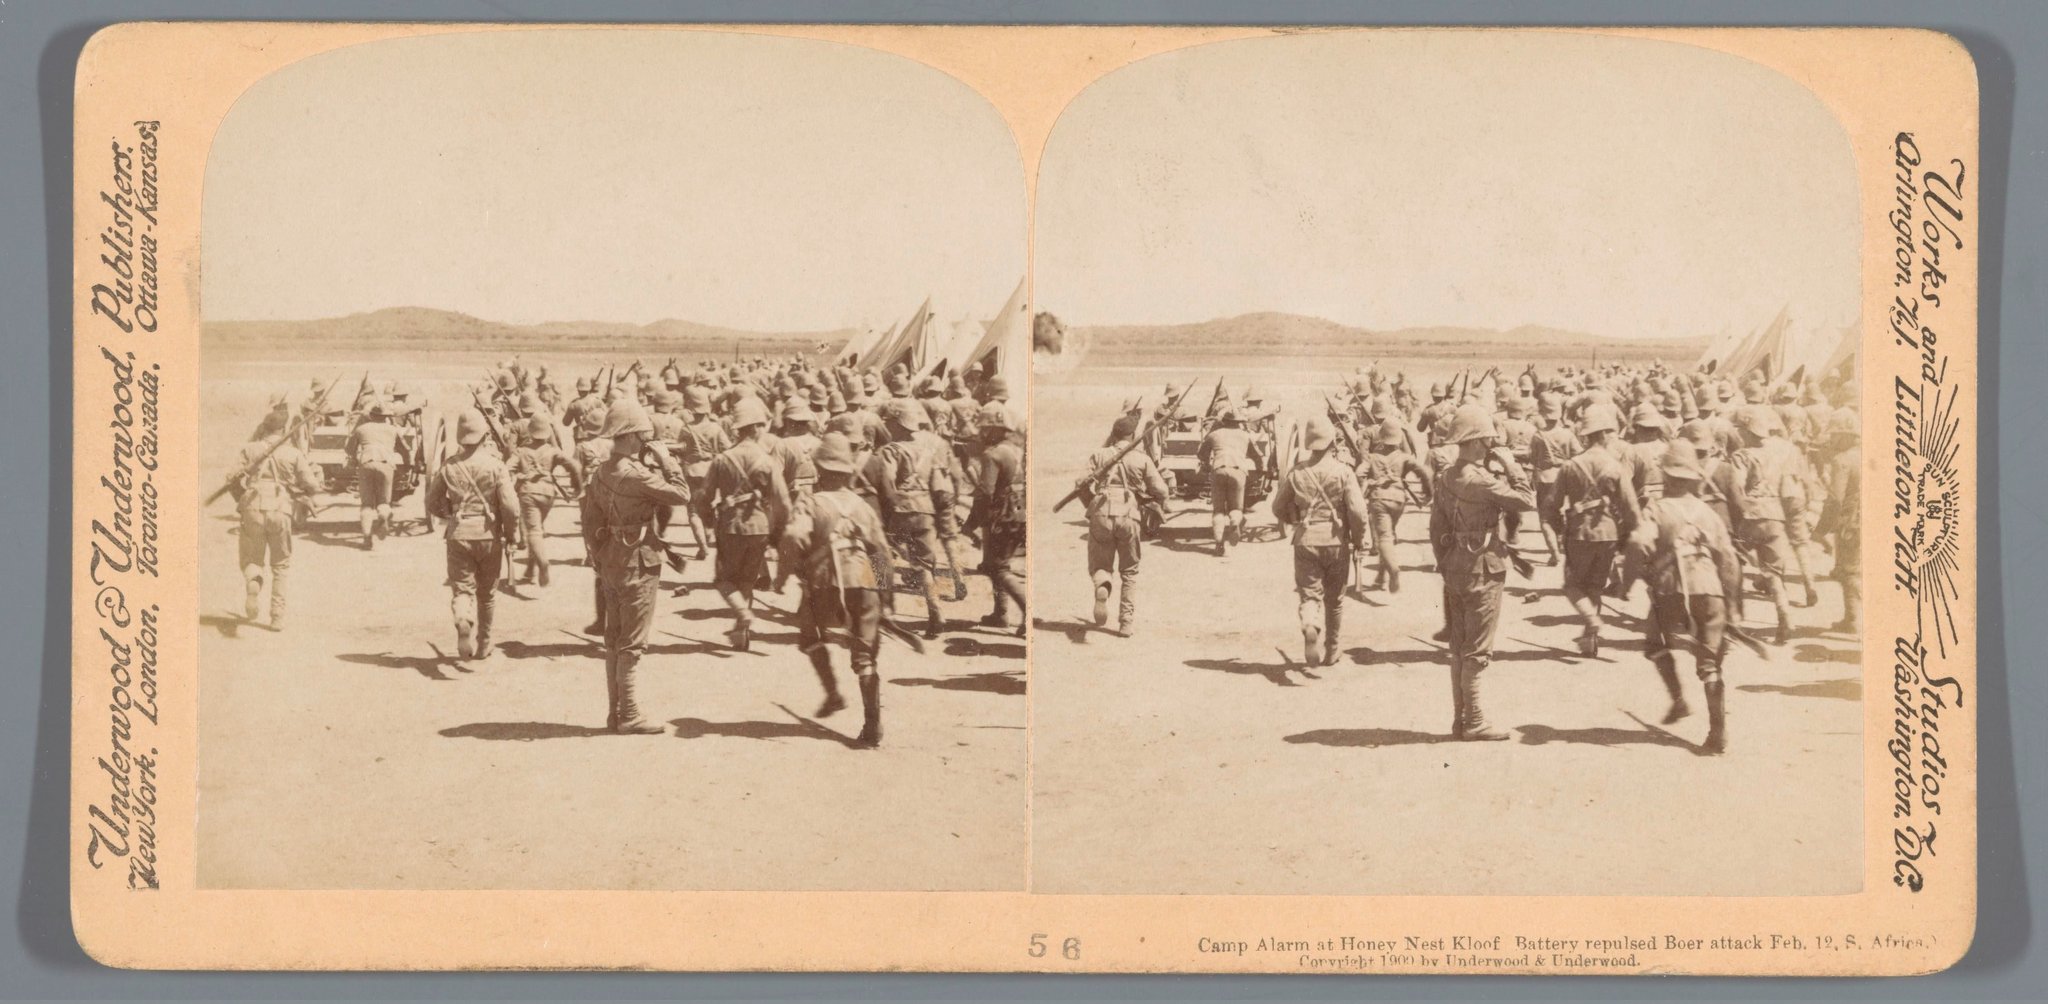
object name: stereograph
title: Gezicht op Britse soldaten op een vlakte bij Honey Nest Kloof nadat een aanval van de Boeren is afgewend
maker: Anonymous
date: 1900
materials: cardboard, paper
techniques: albumen print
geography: honey nest kloof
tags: (military) camp with tents, the soldier; the soldier's life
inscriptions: inscription: ‘Works and Studios ~/ Arlington, N.J. Littleton, N.H. Washington, D.C.’, copyright notice: ‘Copyright 1900 by Underwood & Underwood.’, inscription, number: ‘56’